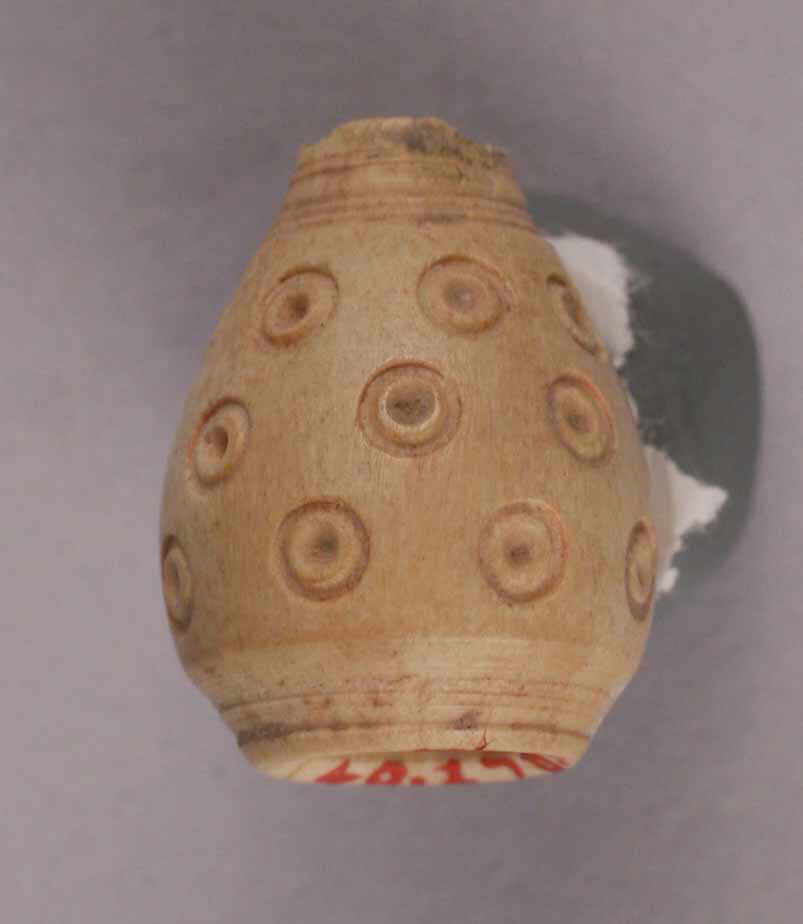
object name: button or bead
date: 801-1000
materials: bone, paint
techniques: incising, inlay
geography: iran